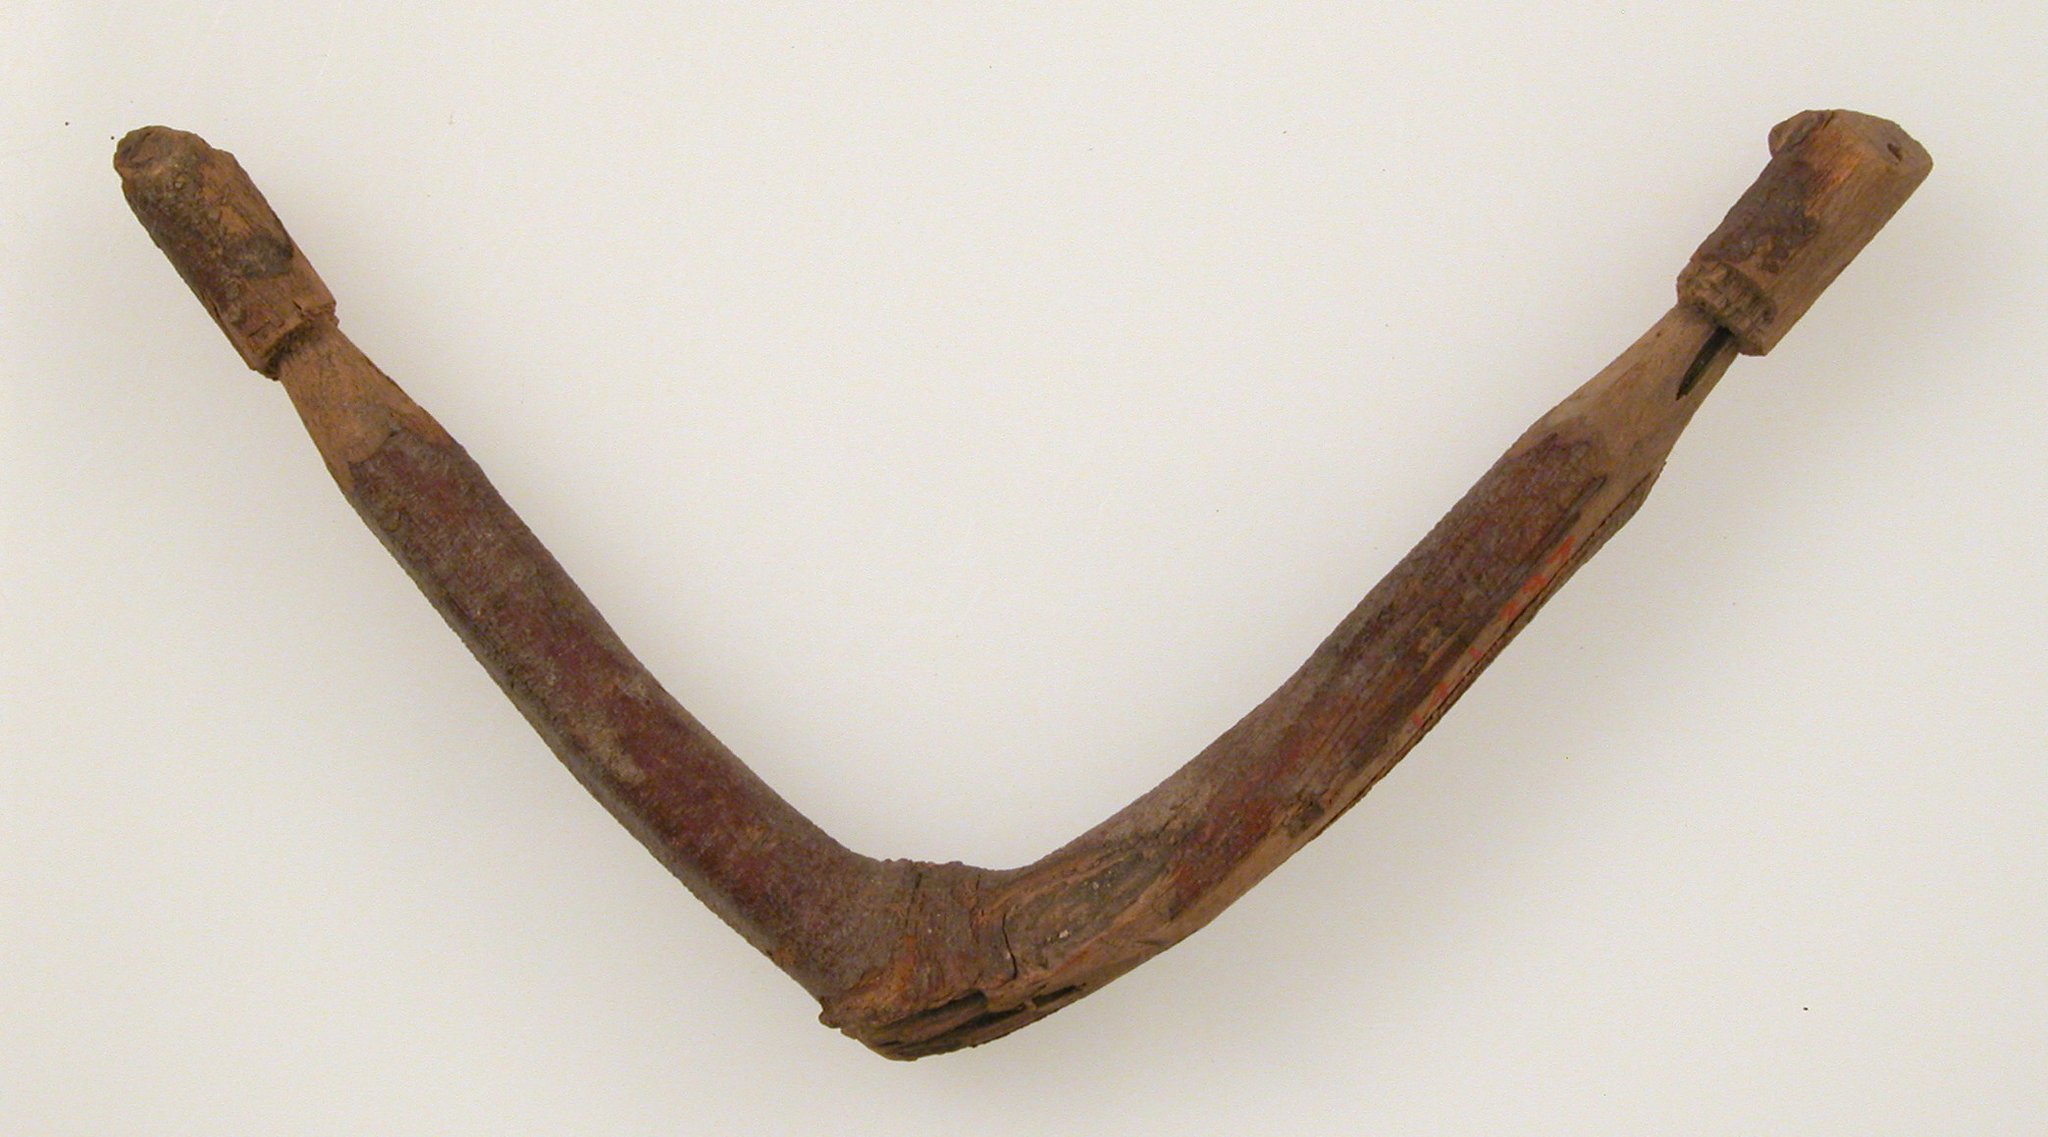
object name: pulley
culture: coptic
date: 580-640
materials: wood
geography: egypt